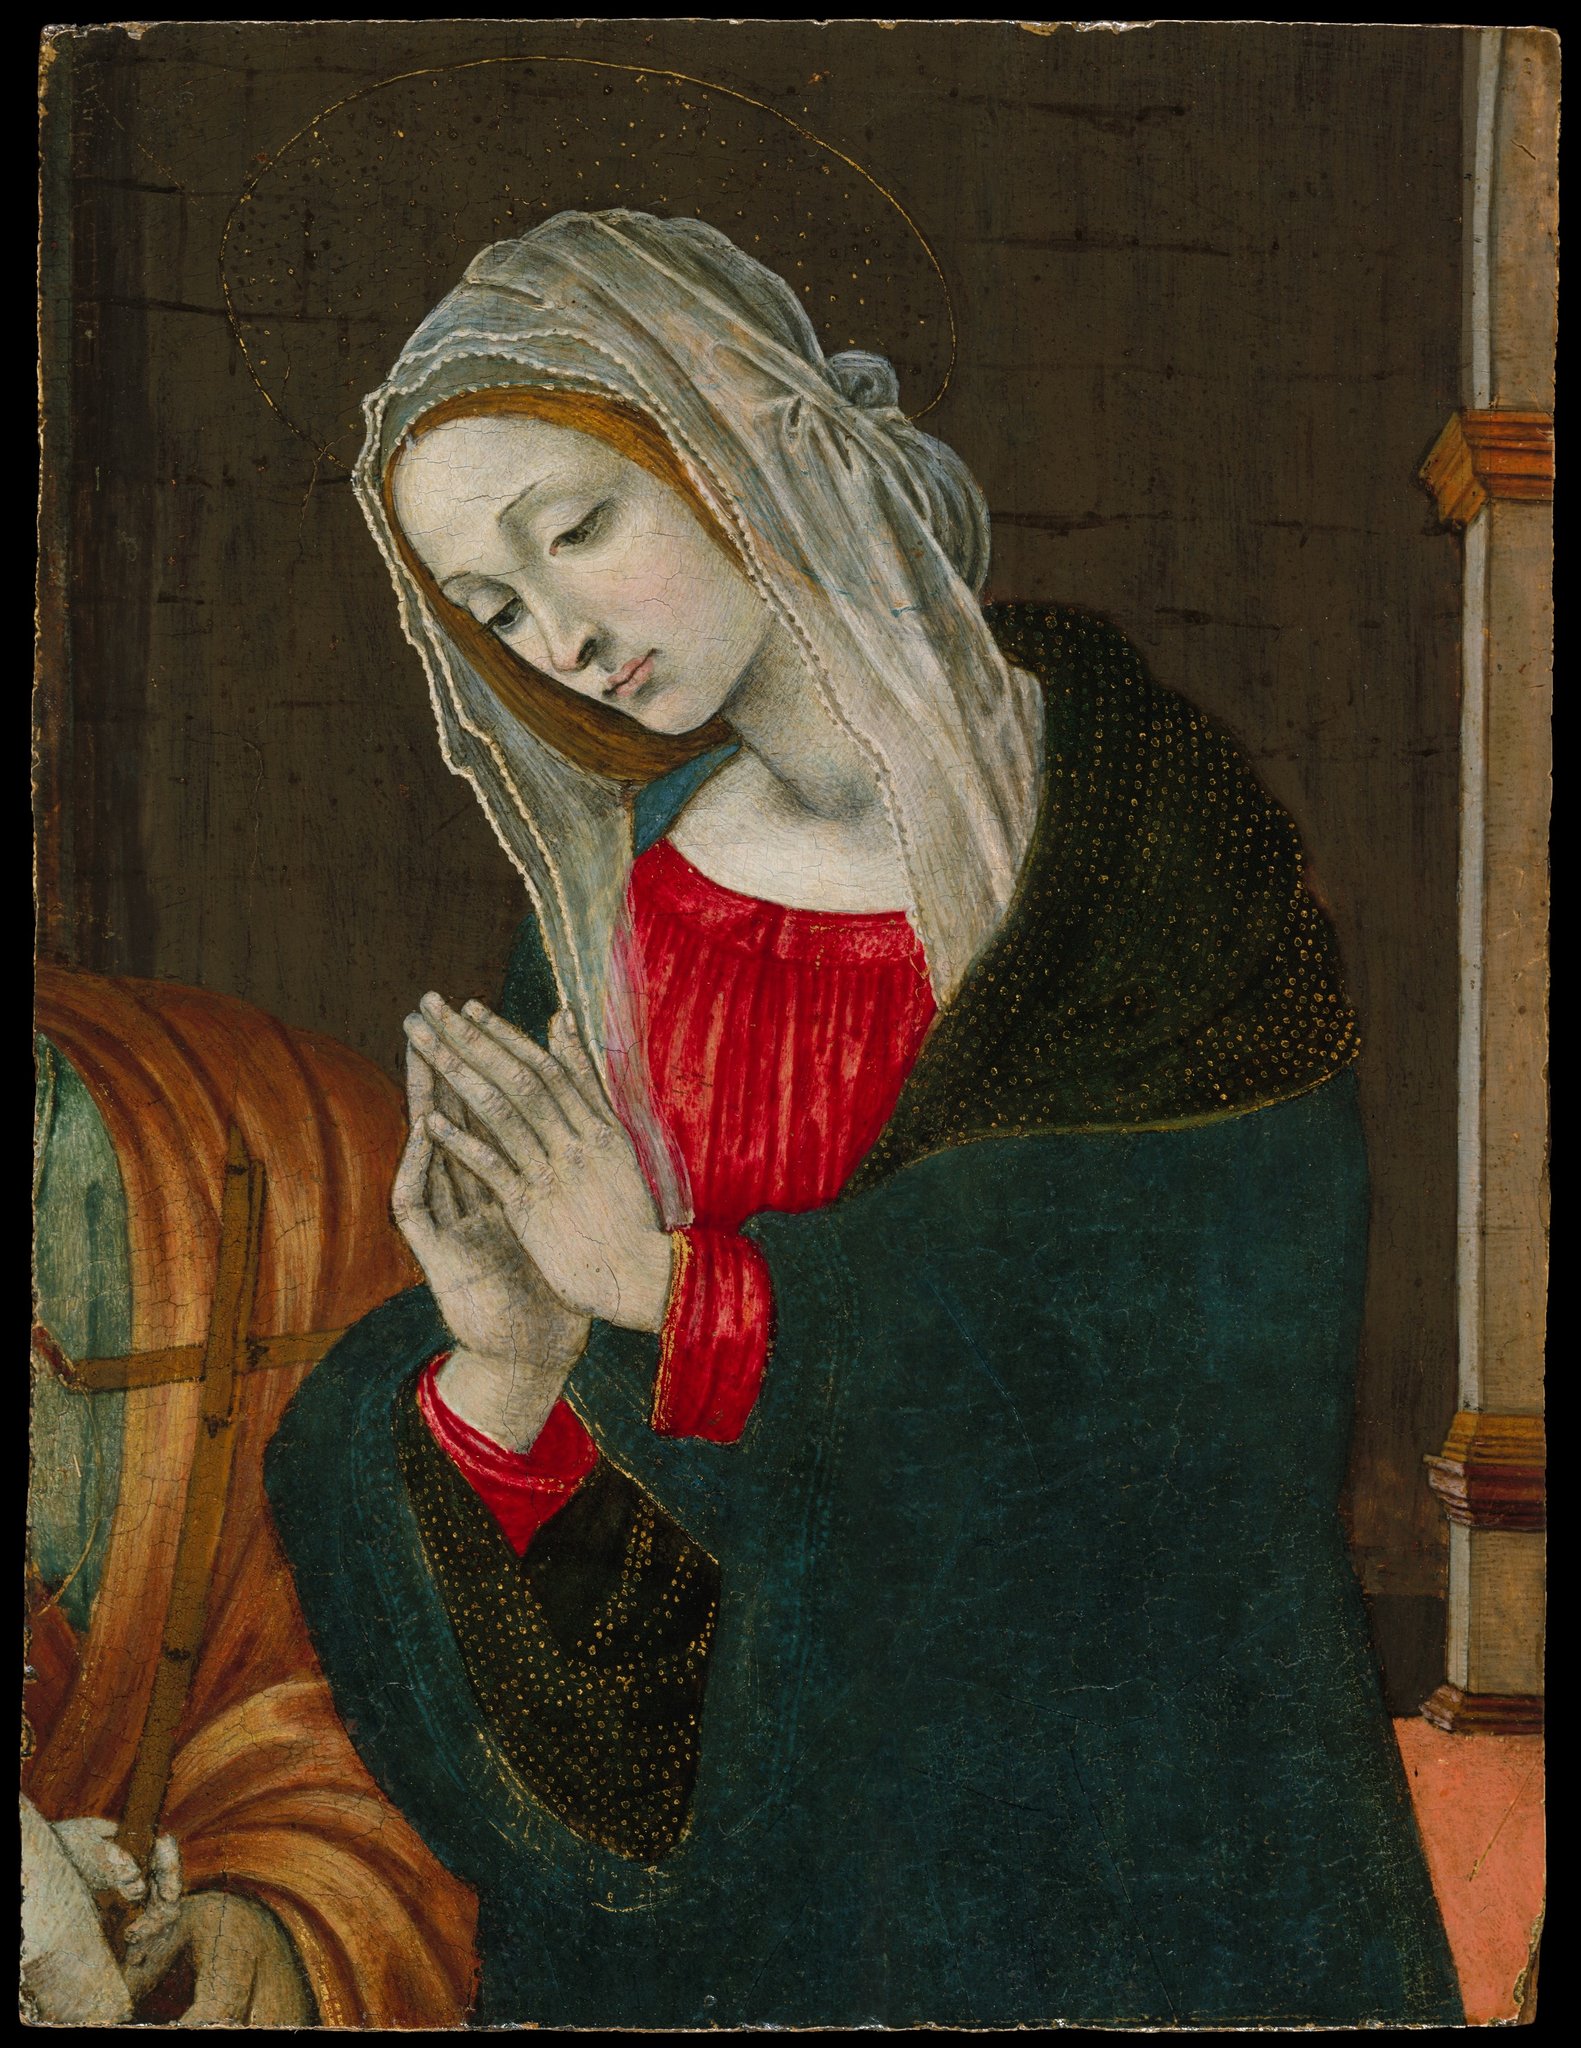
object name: painting fragment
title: The Virgin of the Nativity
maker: filippino lippi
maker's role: artist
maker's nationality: italian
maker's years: 1457-1504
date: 1500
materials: gold, paint, wood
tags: virgin mary